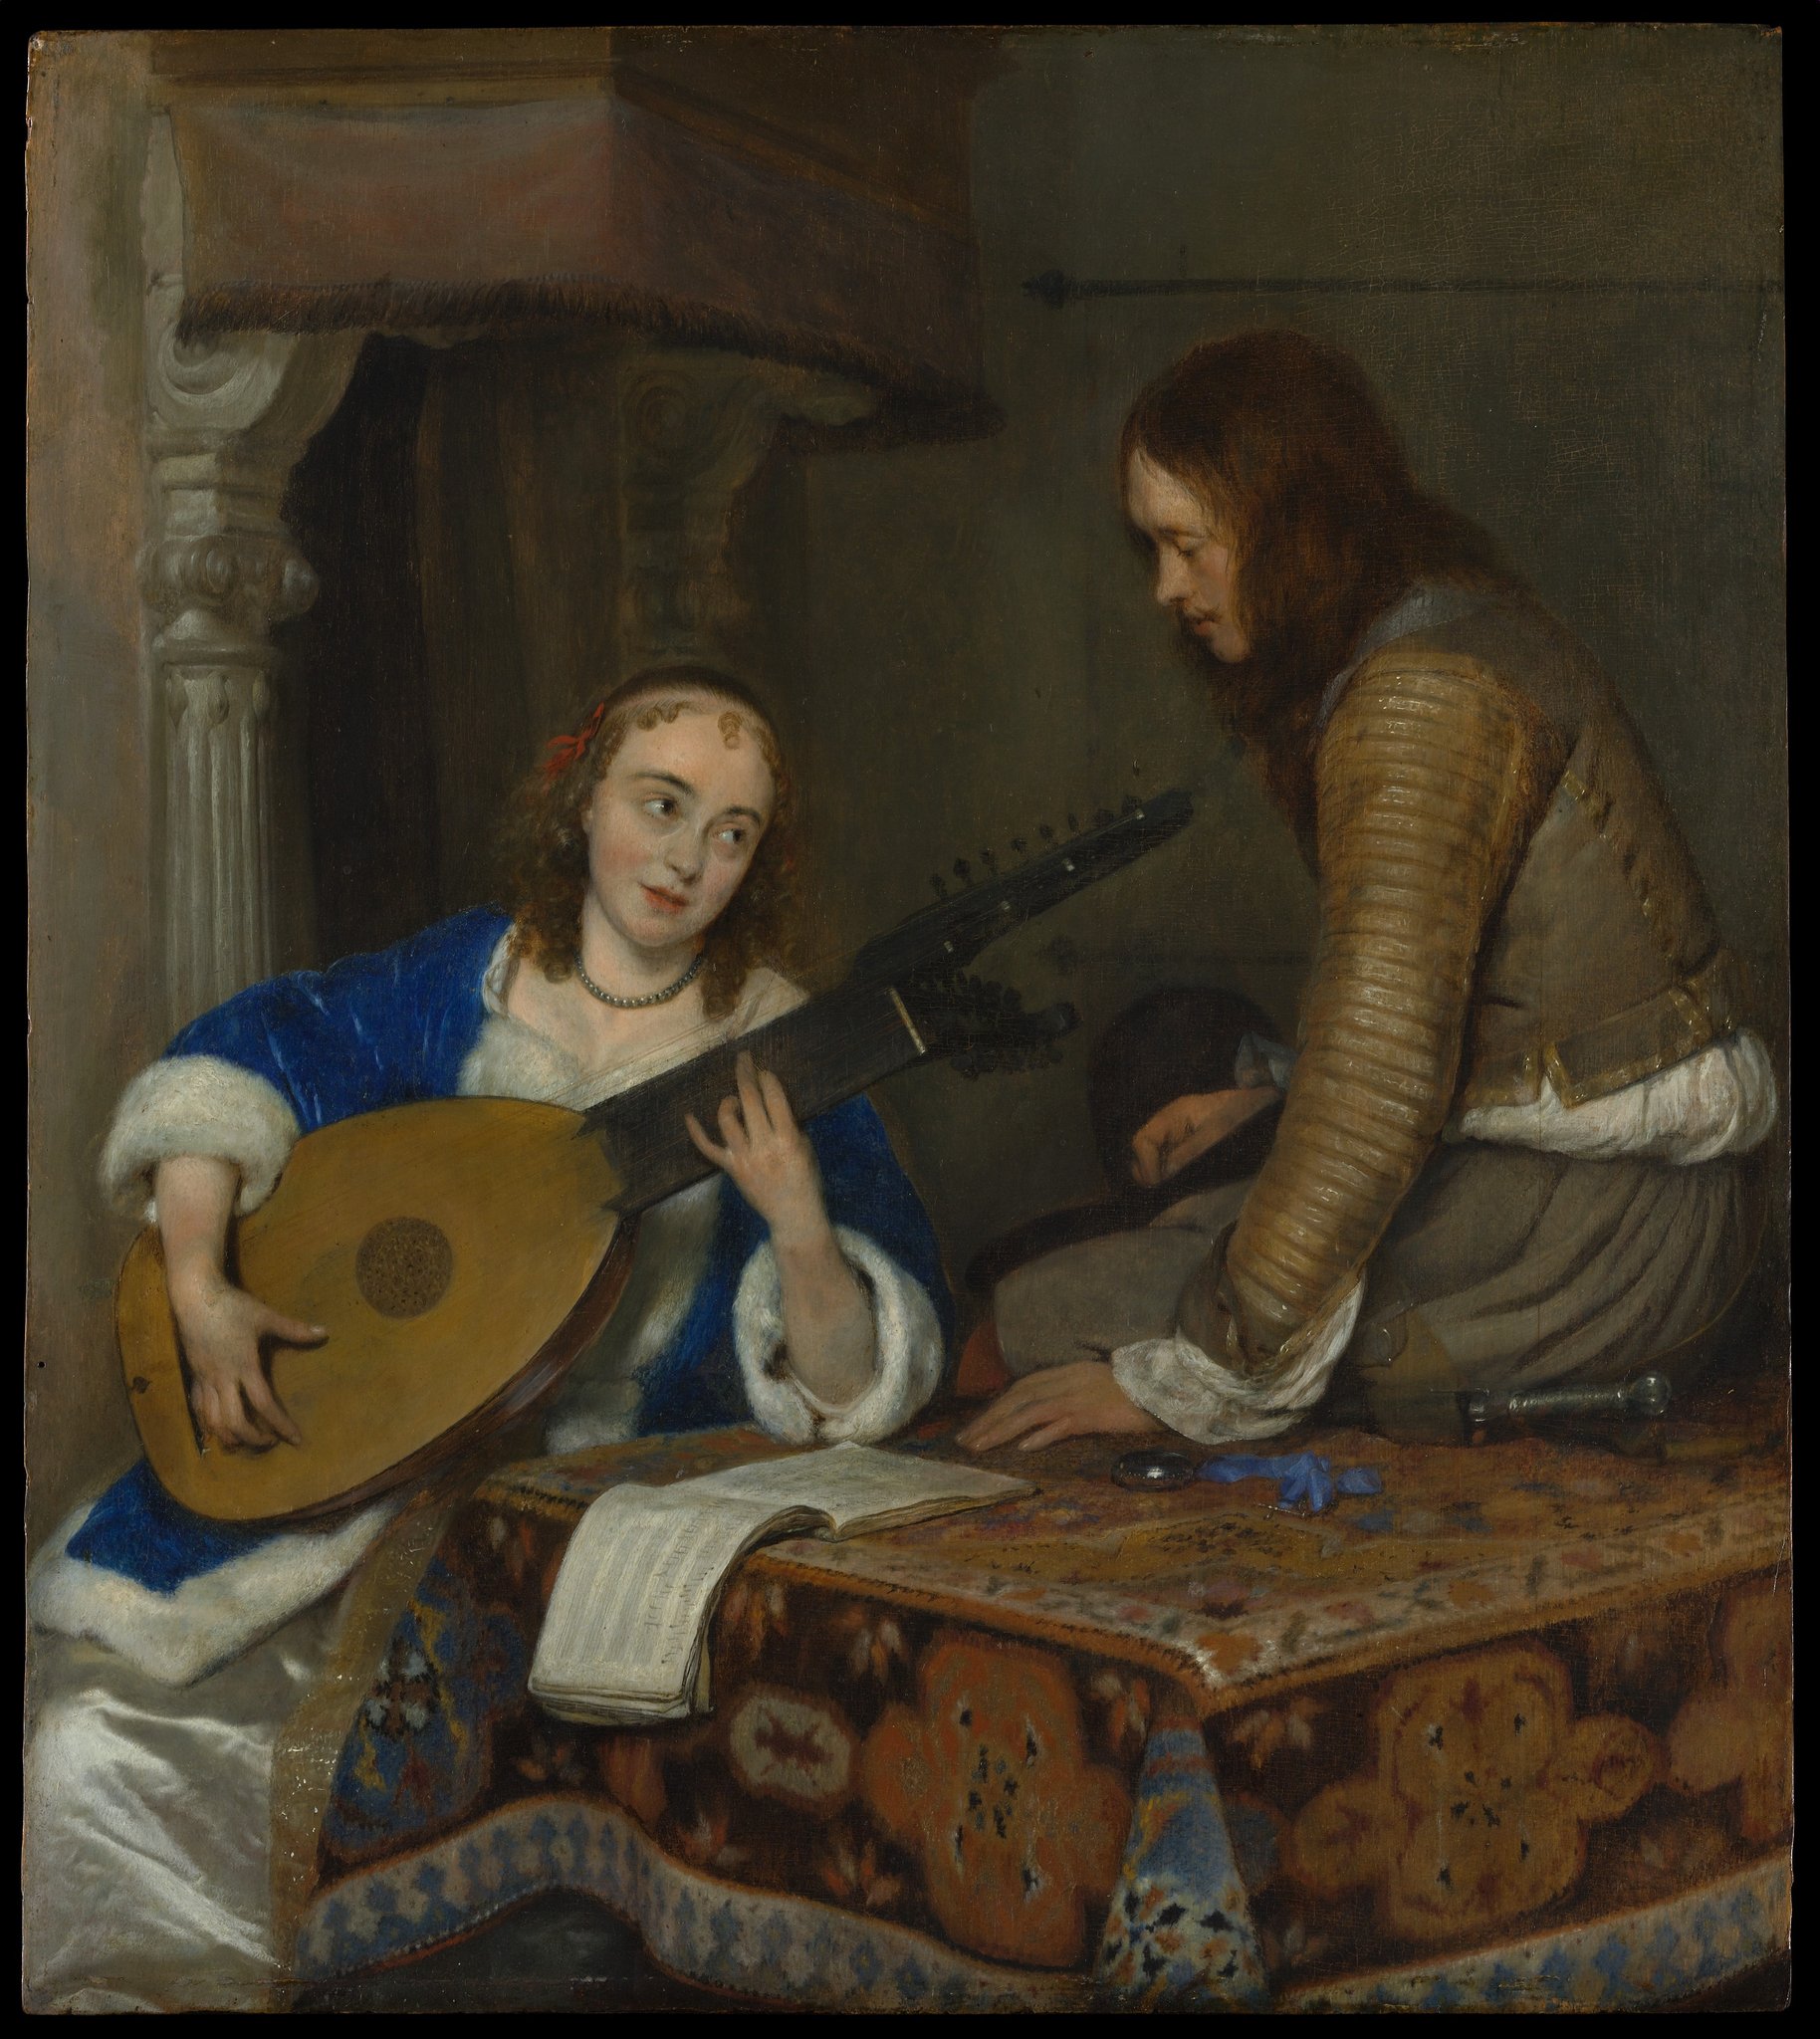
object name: painting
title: A Woman Playing the Theorbo-Lute and a Cavalier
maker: gerard ter borch the younger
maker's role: artist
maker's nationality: dutch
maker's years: 1617-1681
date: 1658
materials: oil, wood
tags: men,women,music,lutes